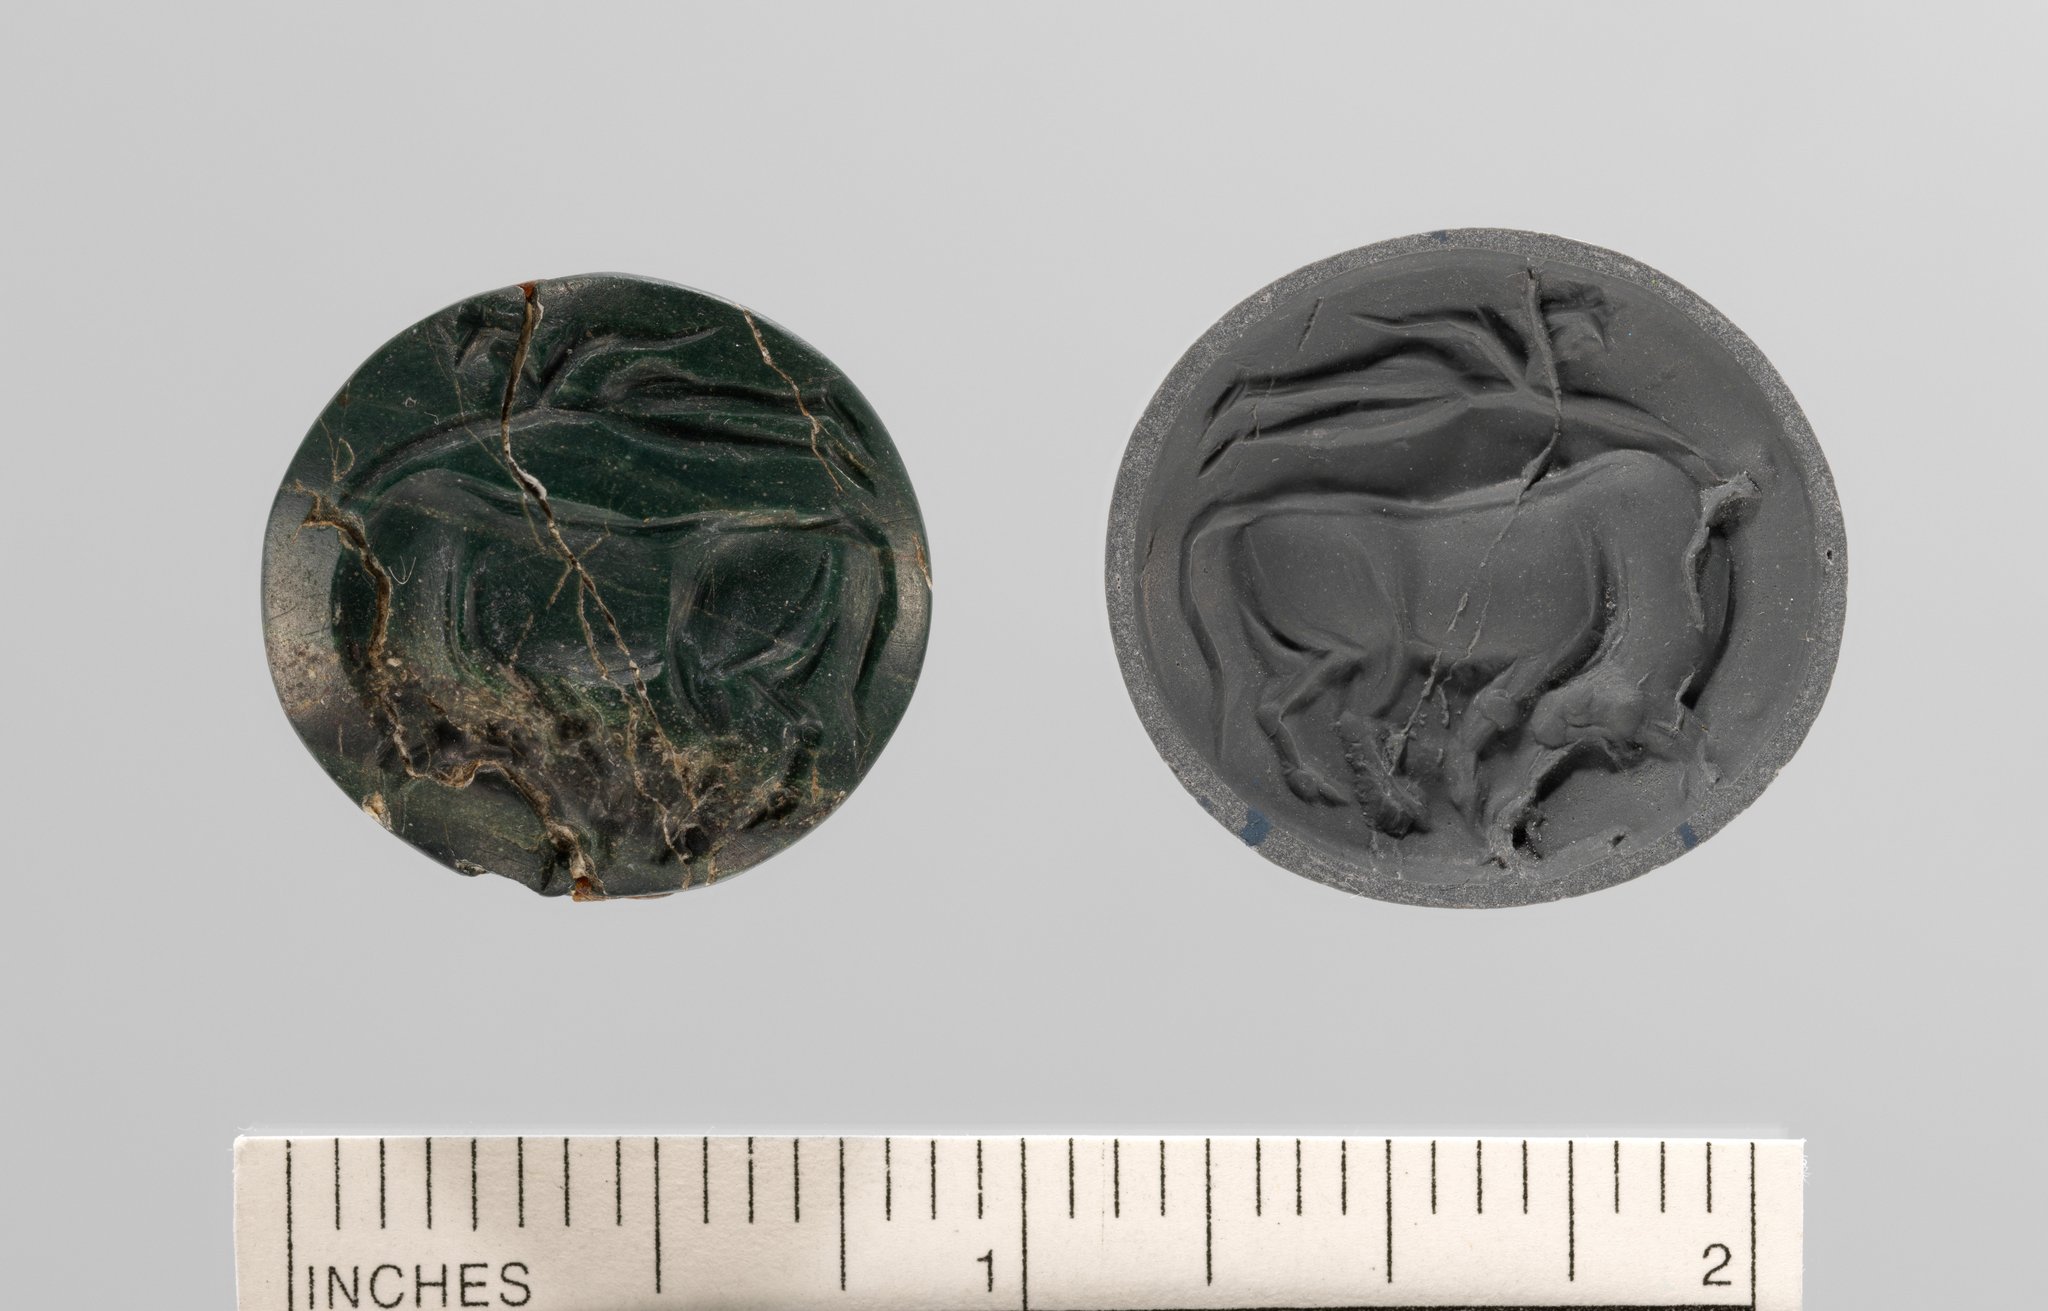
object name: seal, lentoid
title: Jasper Lentoid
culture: minoan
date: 1450-1375 BCE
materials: jasper